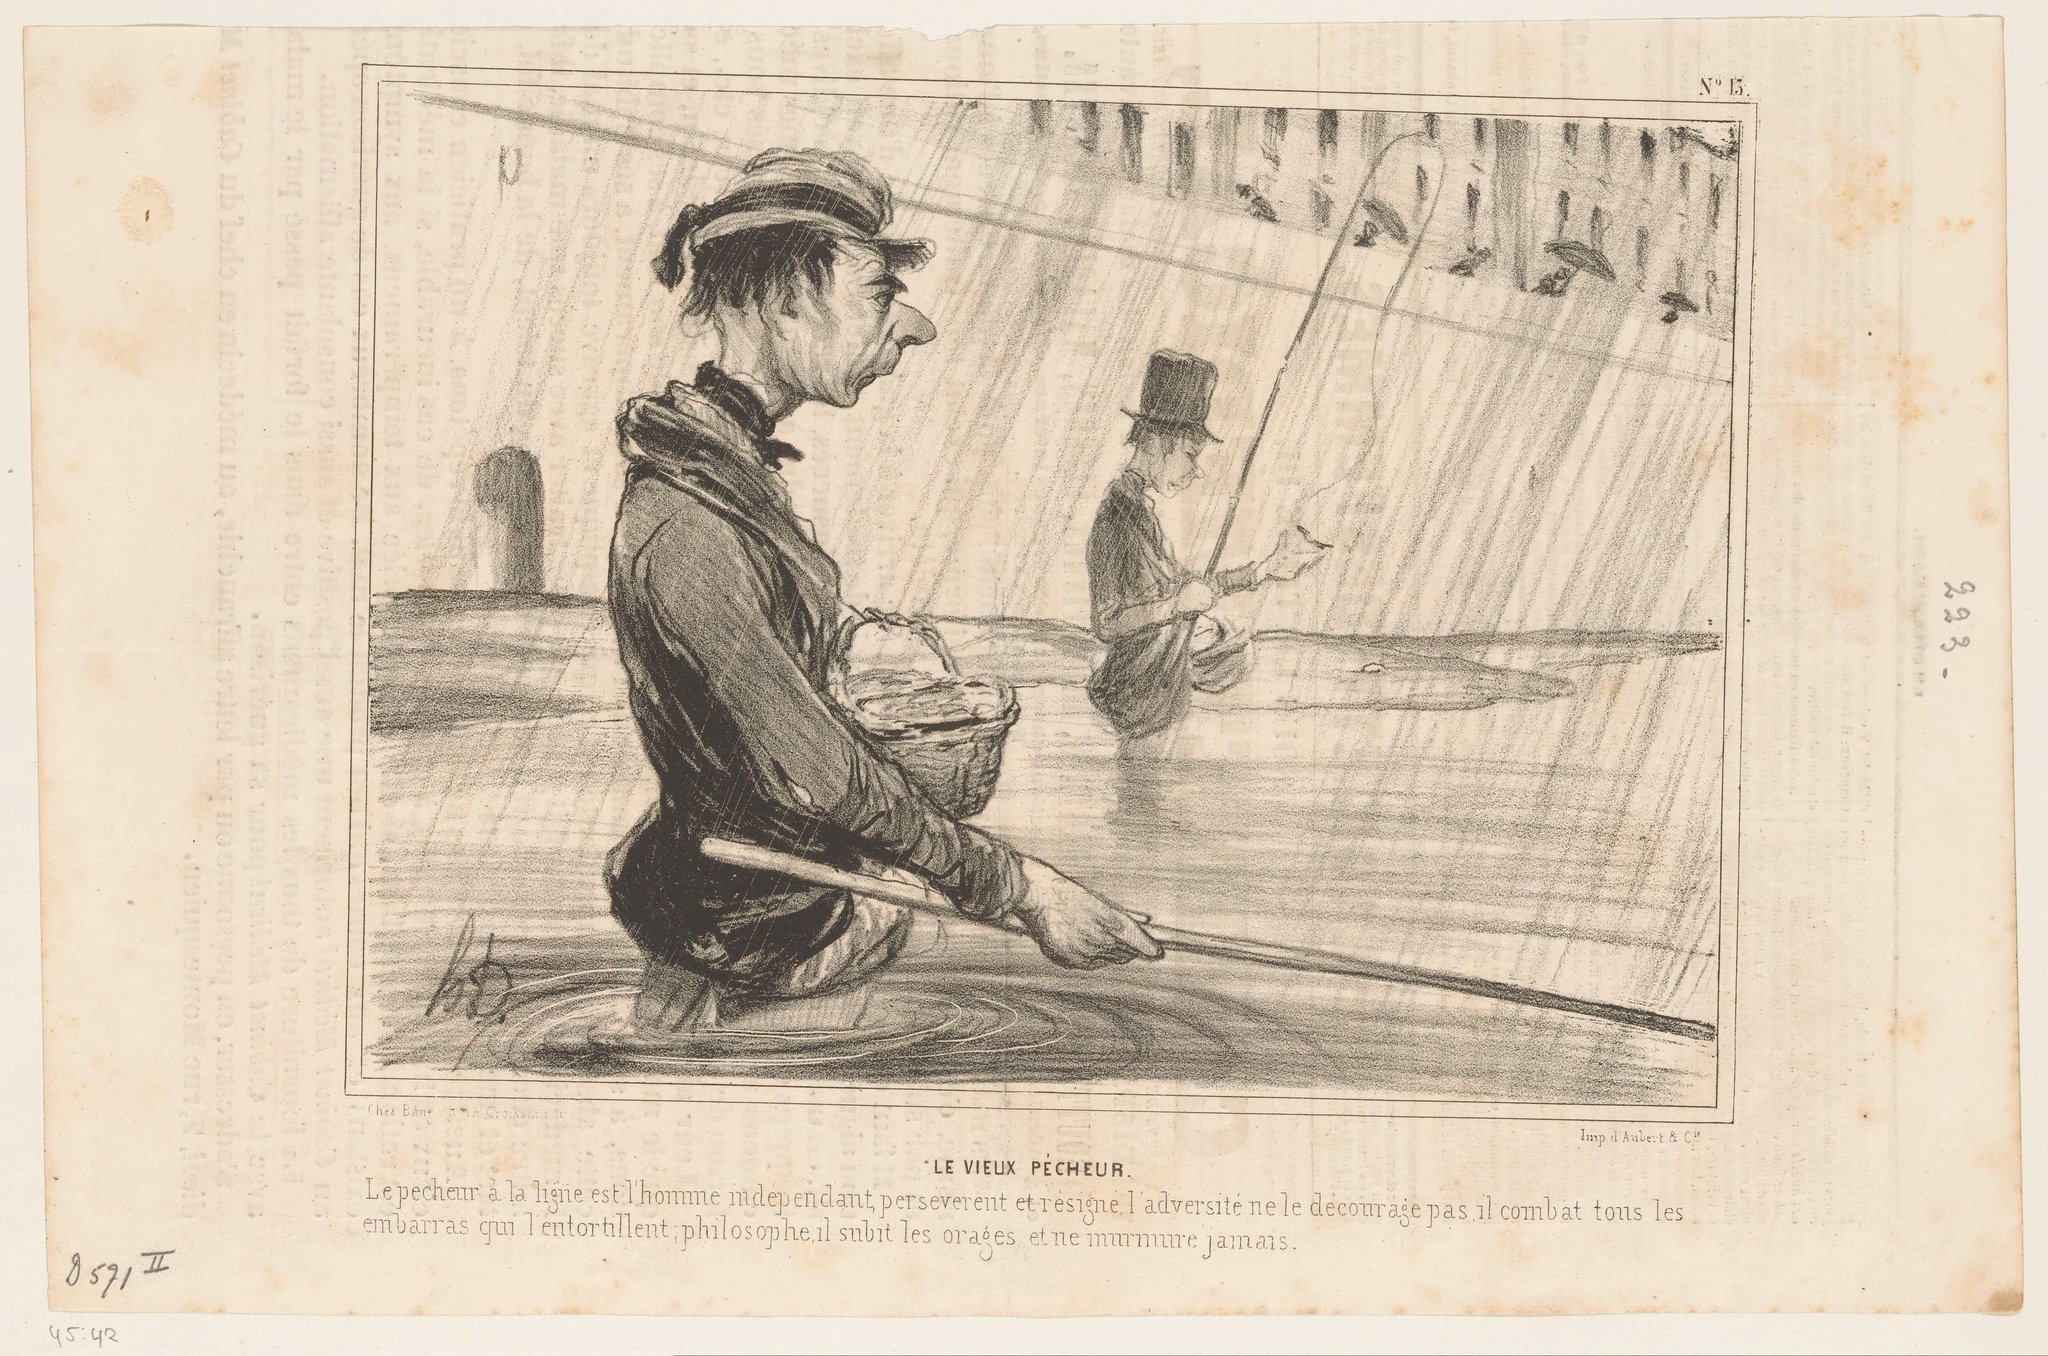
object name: cartoon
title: Parijse types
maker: honoré daumier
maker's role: draughtsman, painter, print maker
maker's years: 1808-1879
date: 1841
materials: paper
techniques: letterpress printing, lithograph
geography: paris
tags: downpour, rain shower, caricatures (human types), fisherman, paris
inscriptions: collector's mark: Lugt 2228a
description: Prent uit: Le Charivari, 10 juli 1841. Prent voor het eerst gebruikt in: Le Figaro, 15 september 1839.